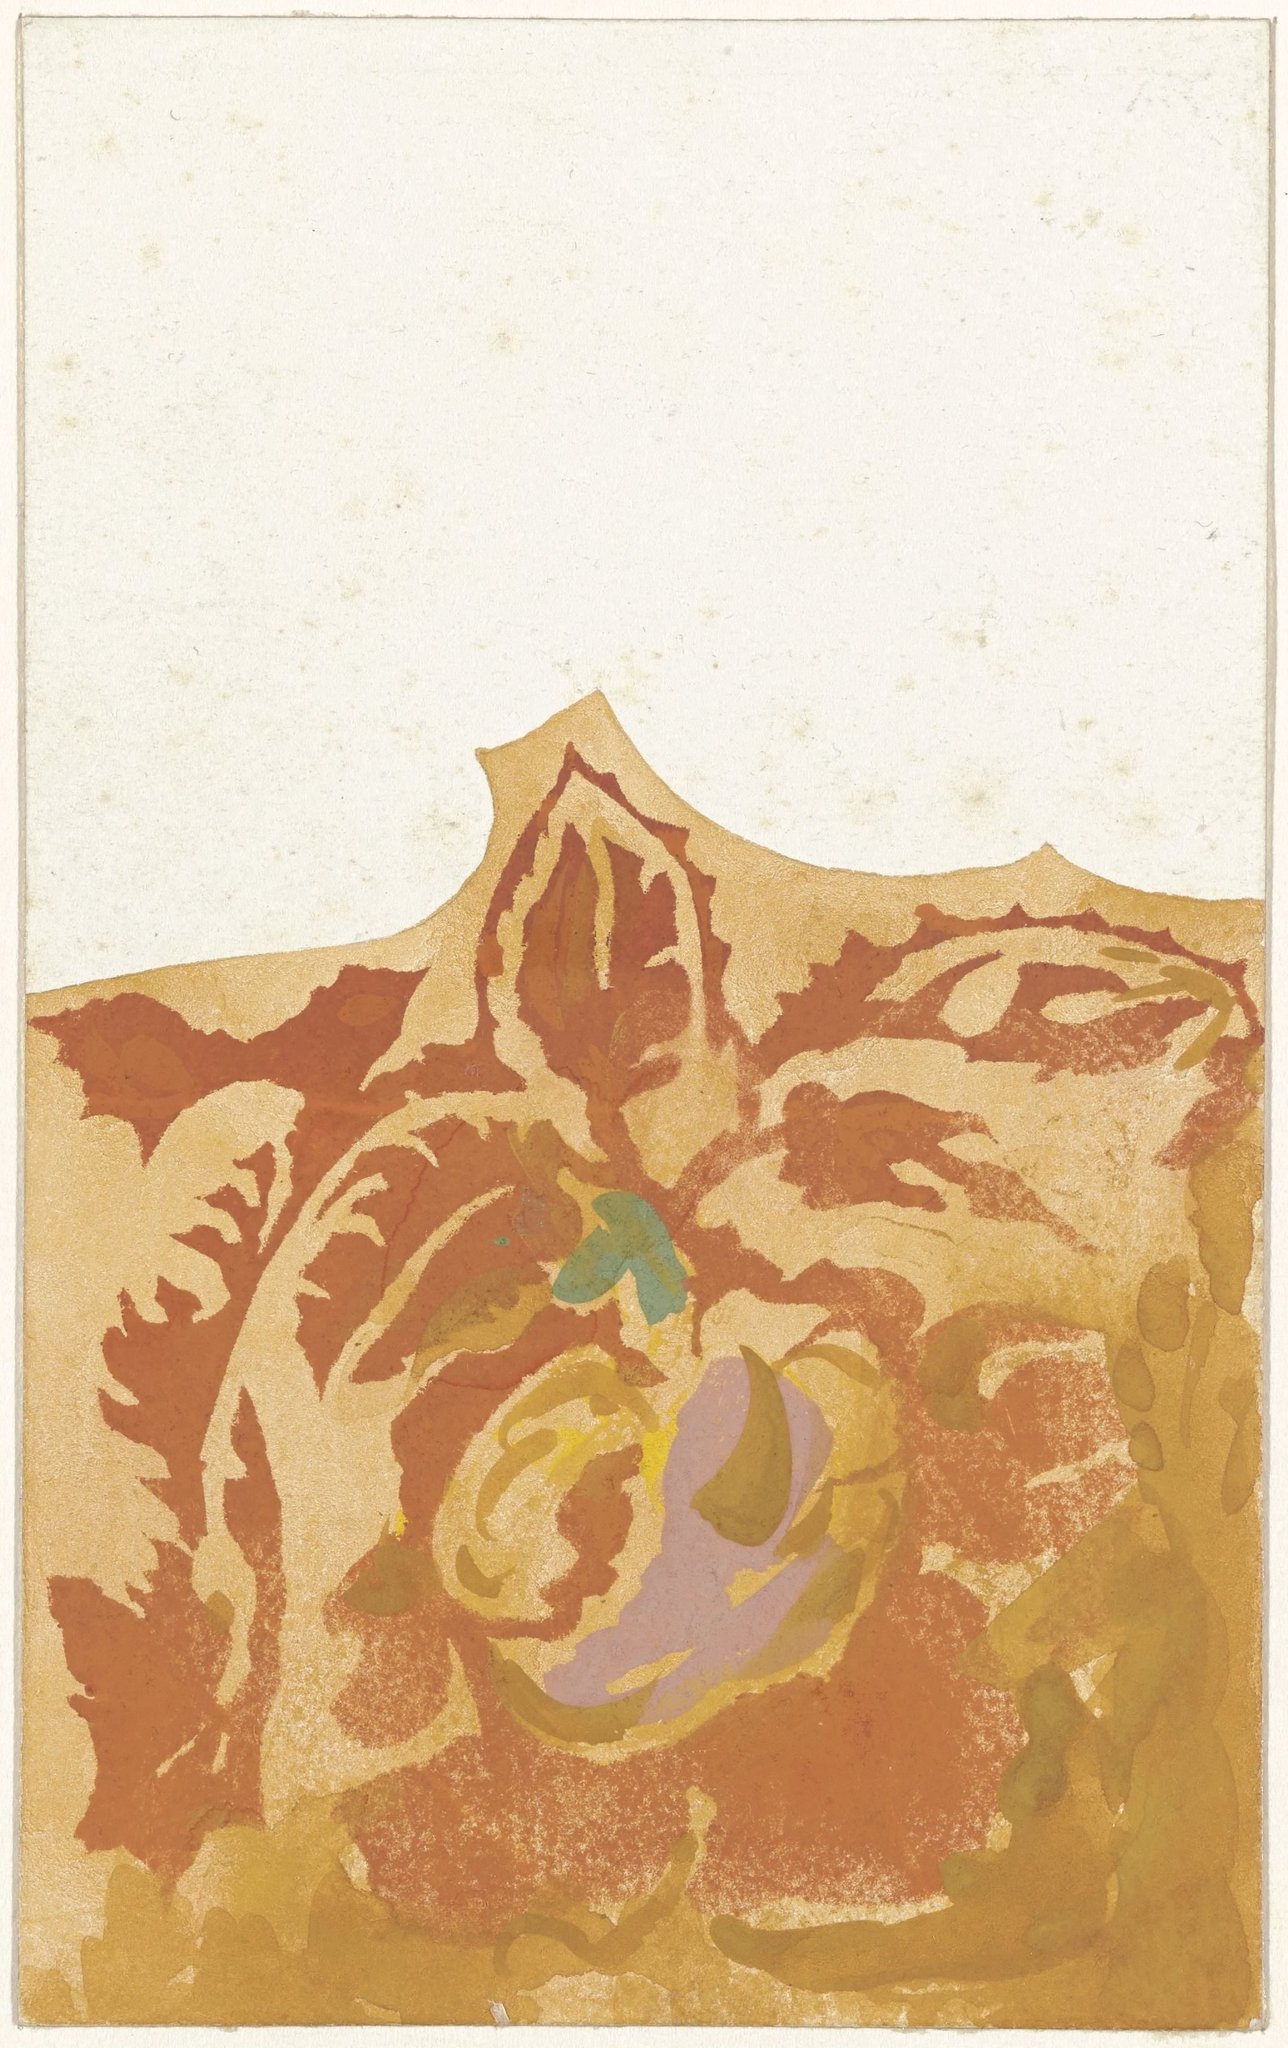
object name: drawing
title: Ontwerptekening voor een menu met plantaardige decoratie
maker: theo colenbrander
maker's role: draughtsman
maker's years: 1841-1930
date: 1851-1930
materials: paper, watercolor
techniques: brush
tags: ornament derived from plant forms